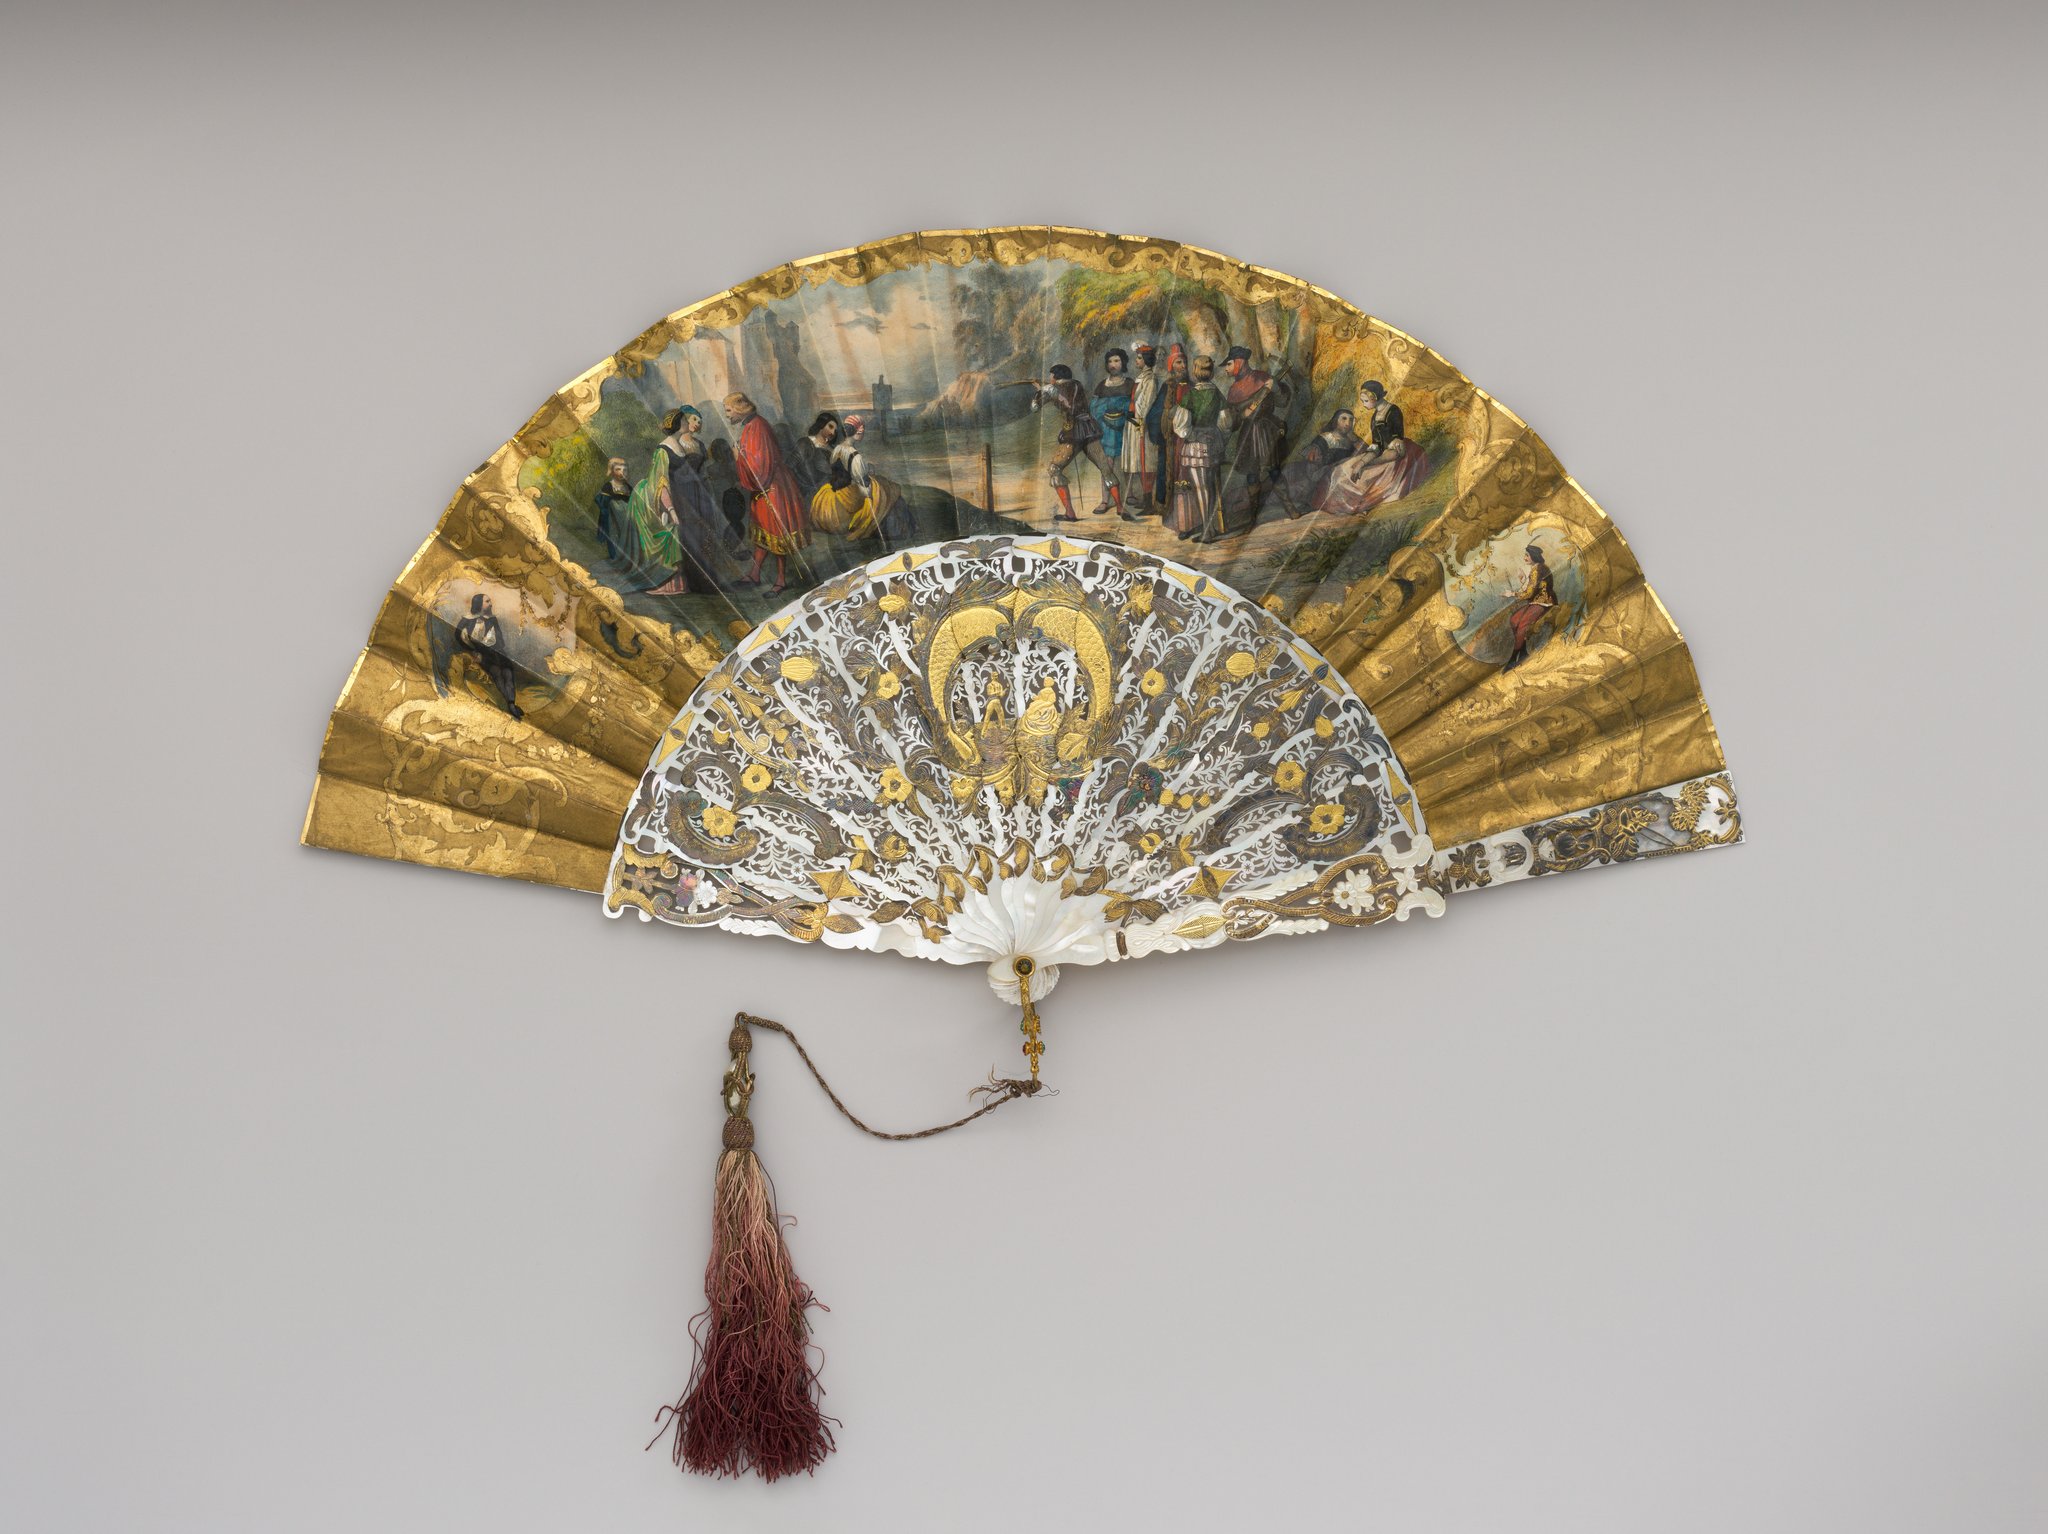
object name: fan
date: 1834-1866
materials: gilt, mother of pearl, paper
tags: landscapes